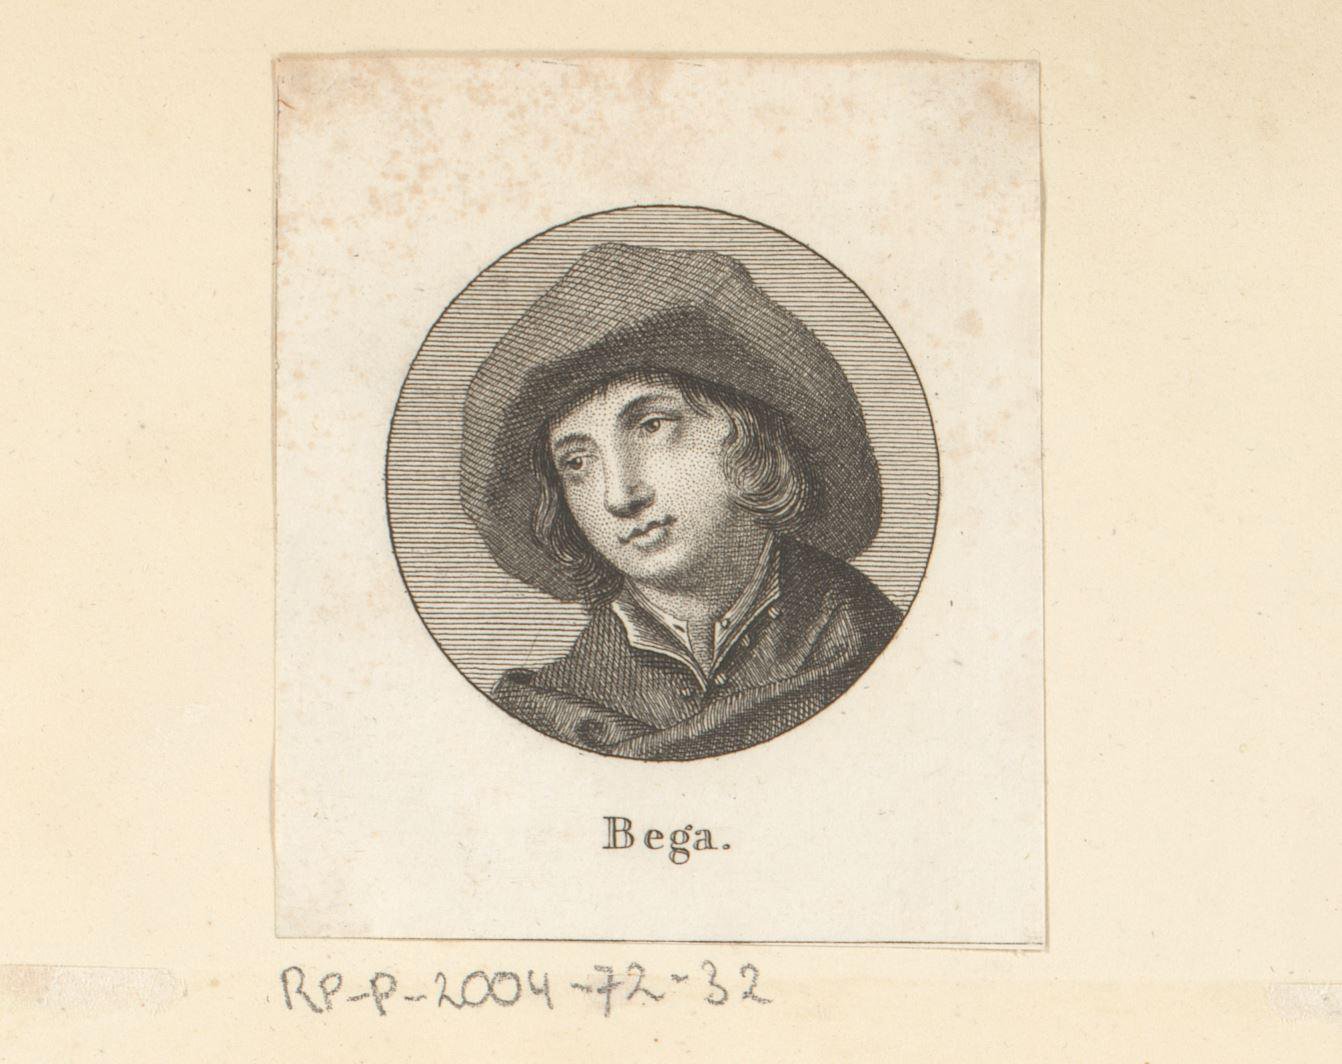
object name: album leaf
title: Portret van Cornelis Bega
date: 1791-1800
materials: paper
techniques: engraving, etching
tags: haarlem, draughtsman, cornelis pietersz. bega, historical persons, portrait, self-portrait of painter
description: De samensteller heeft deze prent in het album geplakt als illustratie bij: Pilkington, Matthew en Johann Heinrich Füssli. A dictionary of painters, from the revival of the art to the present period. 4 dln. Londen: John Crowder, 1805, dl. 1, p. 37.